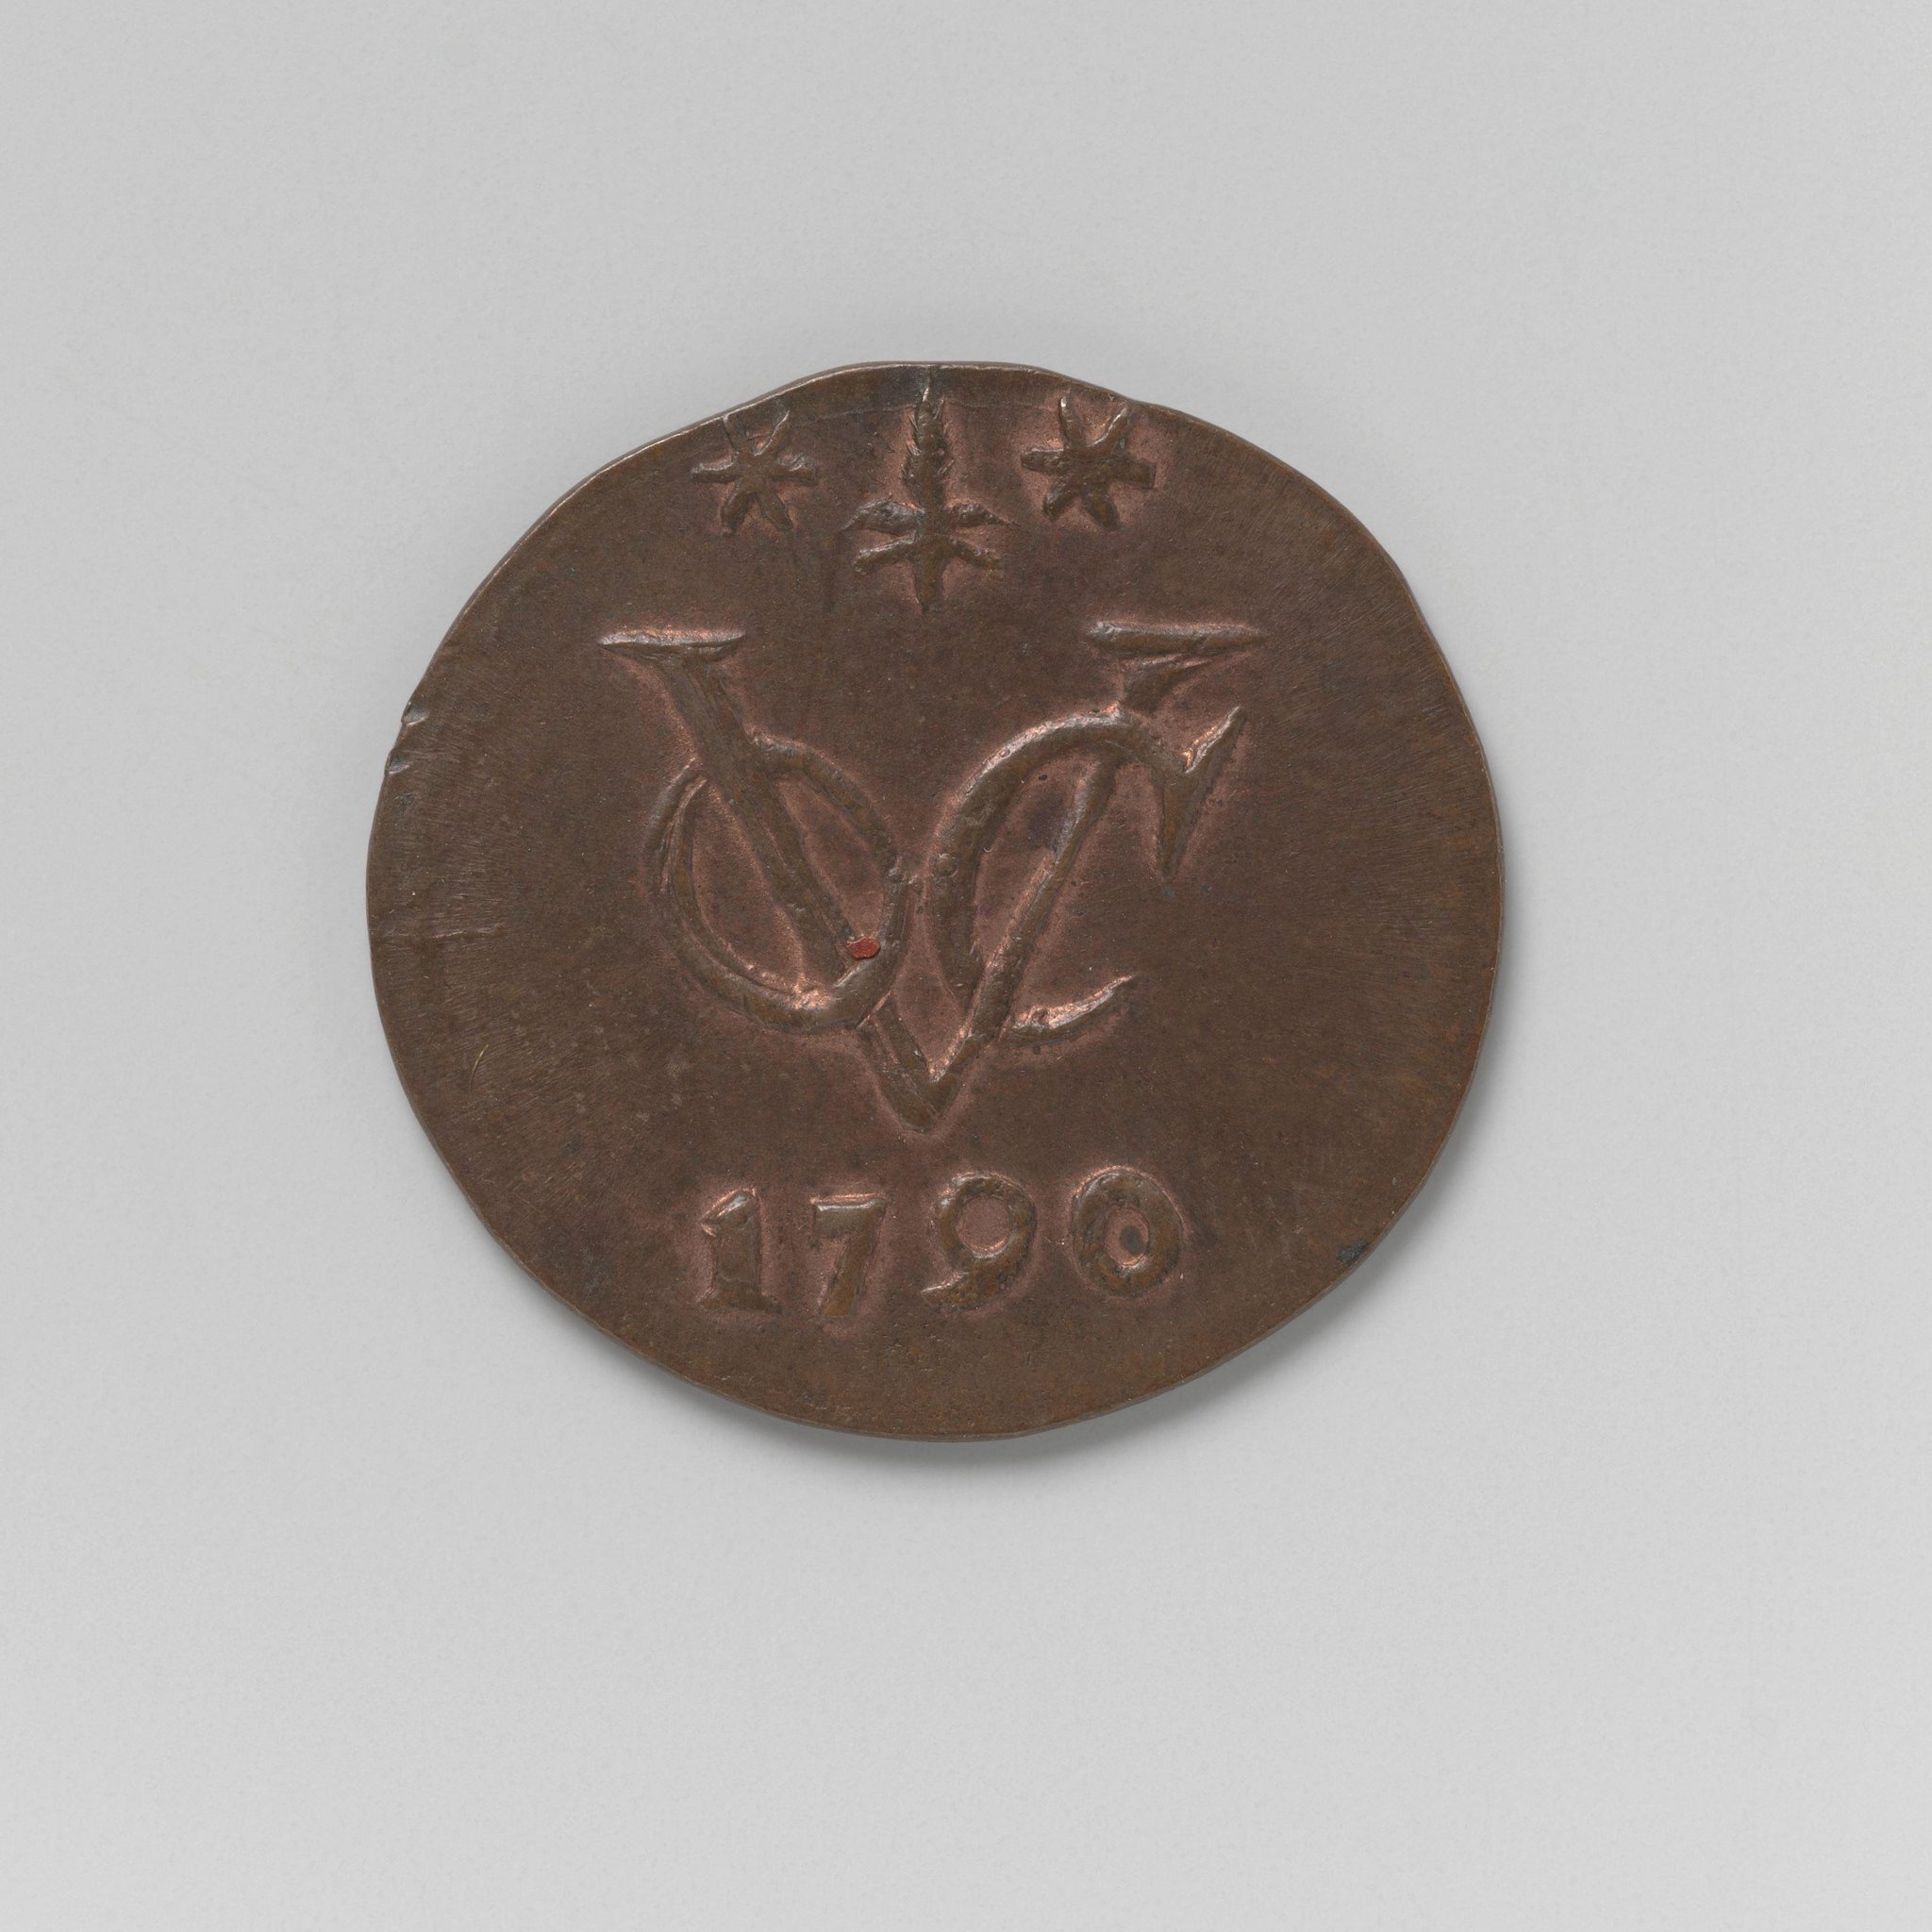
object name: coin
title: ½ duit van de VOC uit Gelderland,1790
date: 1790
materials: copper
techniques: striking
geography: harderwijk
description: Koperen munt. Voorzijde: tussen wapenspreuk gekroond wapenschild van Gelderland. Keerzijde: monogram van de VOC, waarboven muntmeesterteken en waaronder jaartal. Gladde rand.